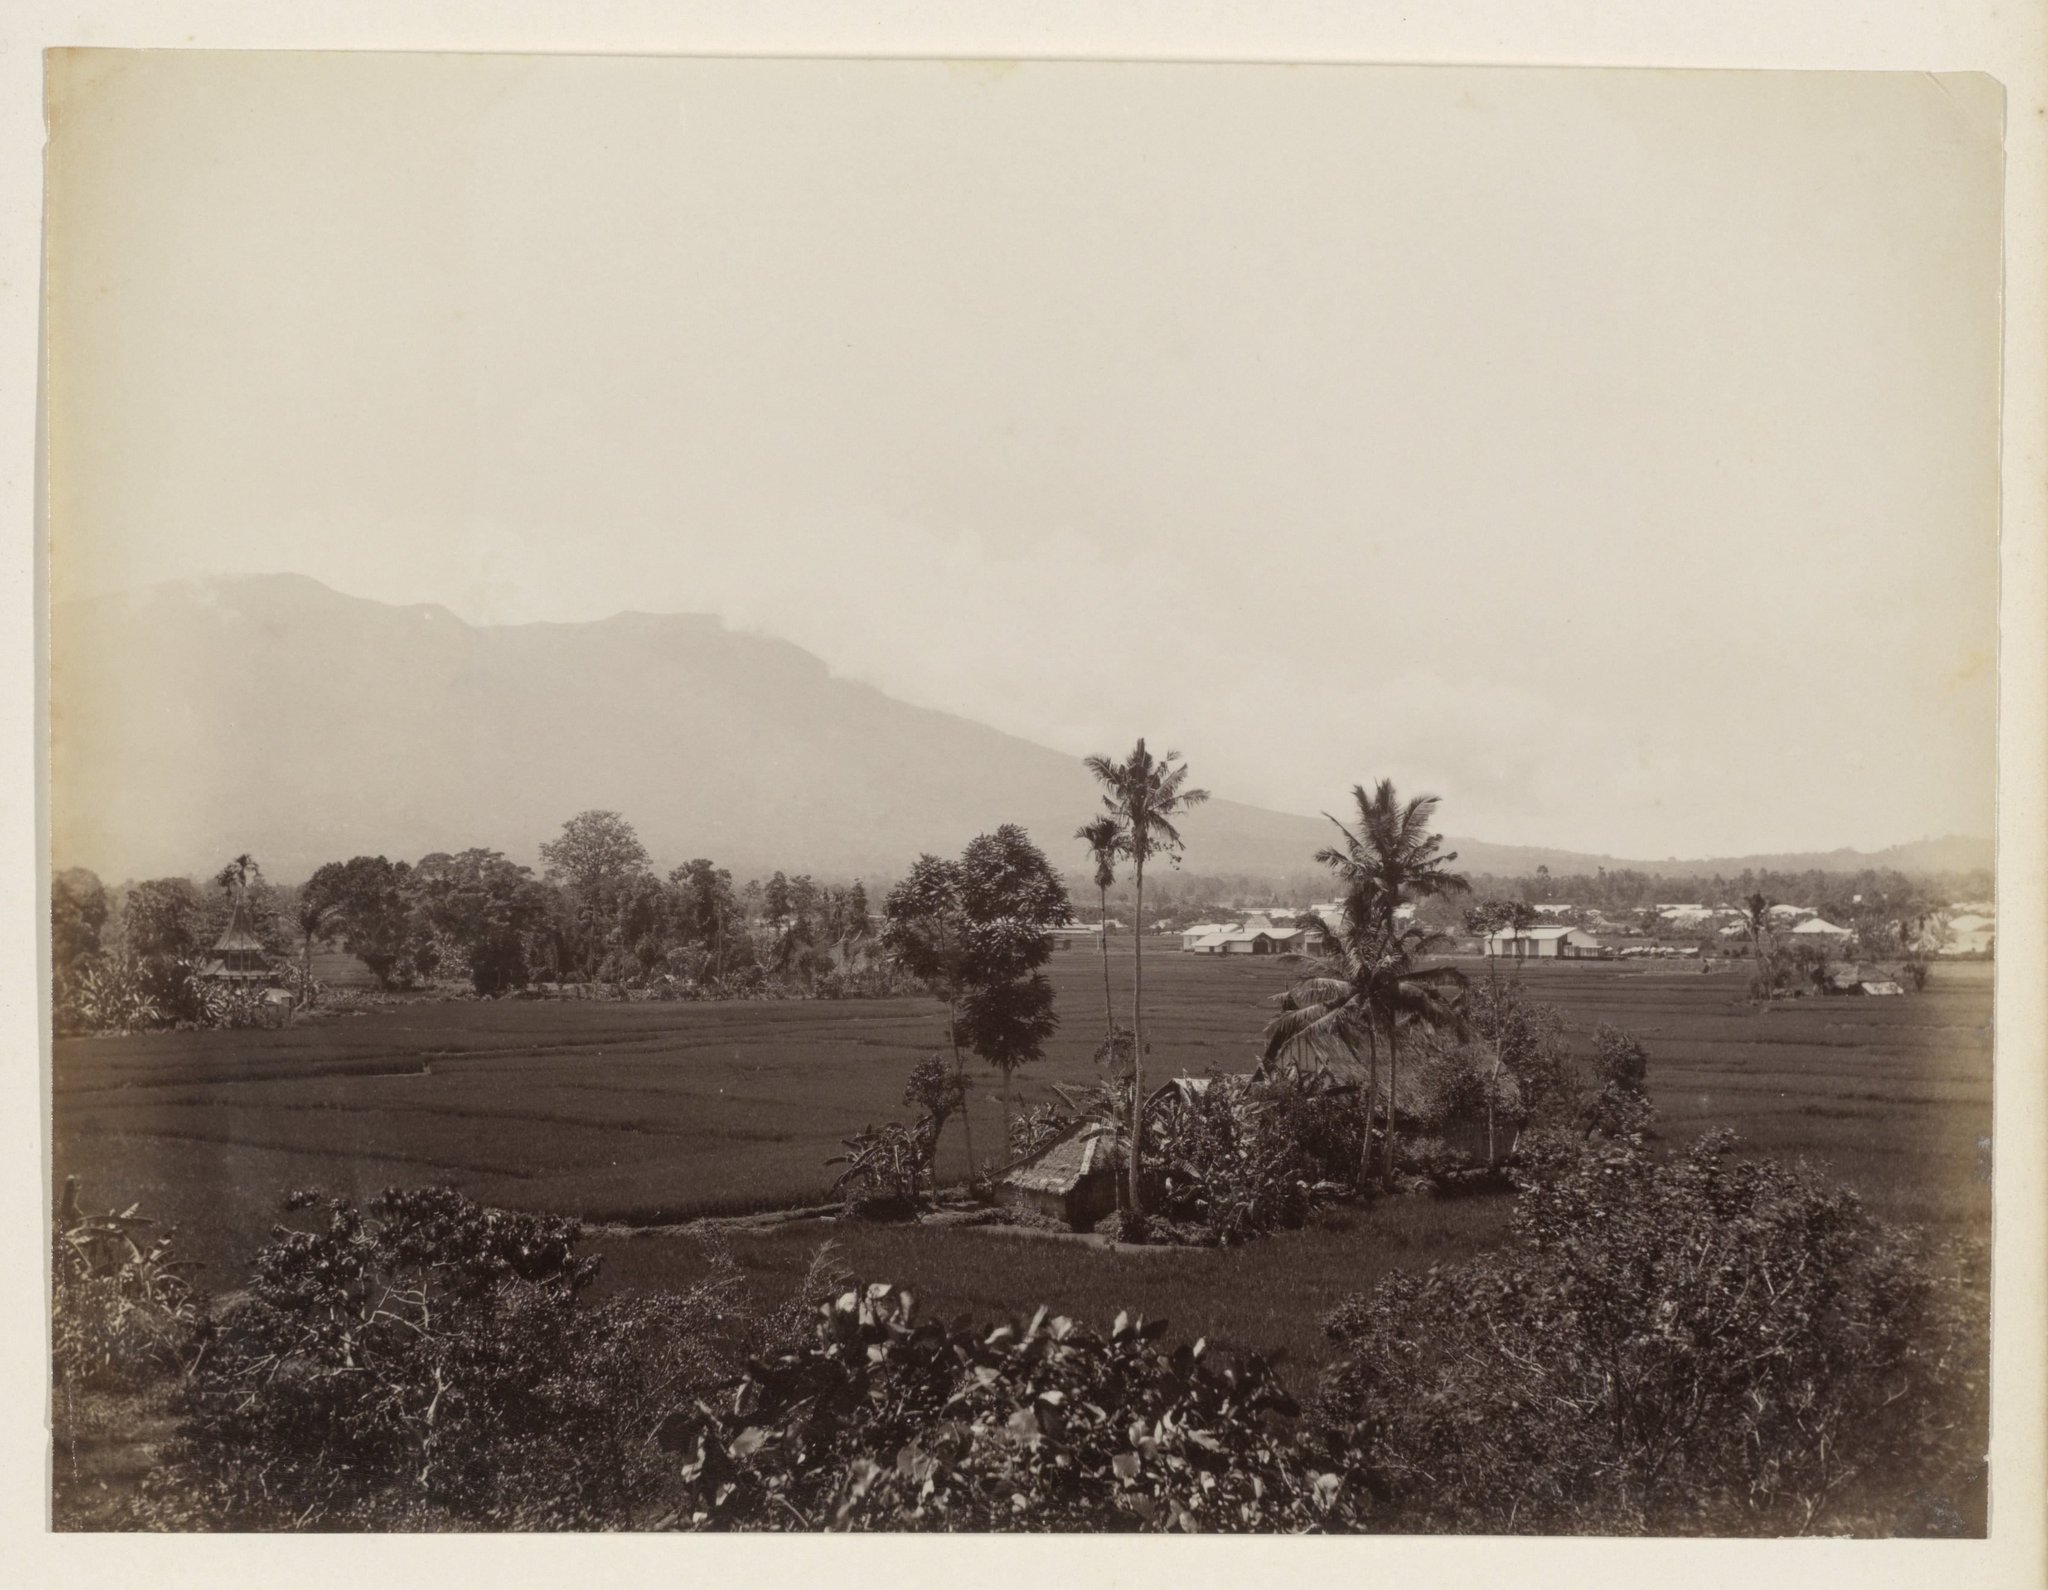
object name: photograph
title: Gezicht op Fort de Kock op Sumatra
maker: Anonymous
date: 1860-1900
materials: paper, photographic support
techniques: albumen print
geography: sumatra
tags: fortress, sumatra, dutch east indies, the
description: Onderdeel van Fotoalbum van een reis door de Verenigde Staten, Honolulu, Nederlands-Indië, Aden, Zanzibar en Zuidelijk Afrika.